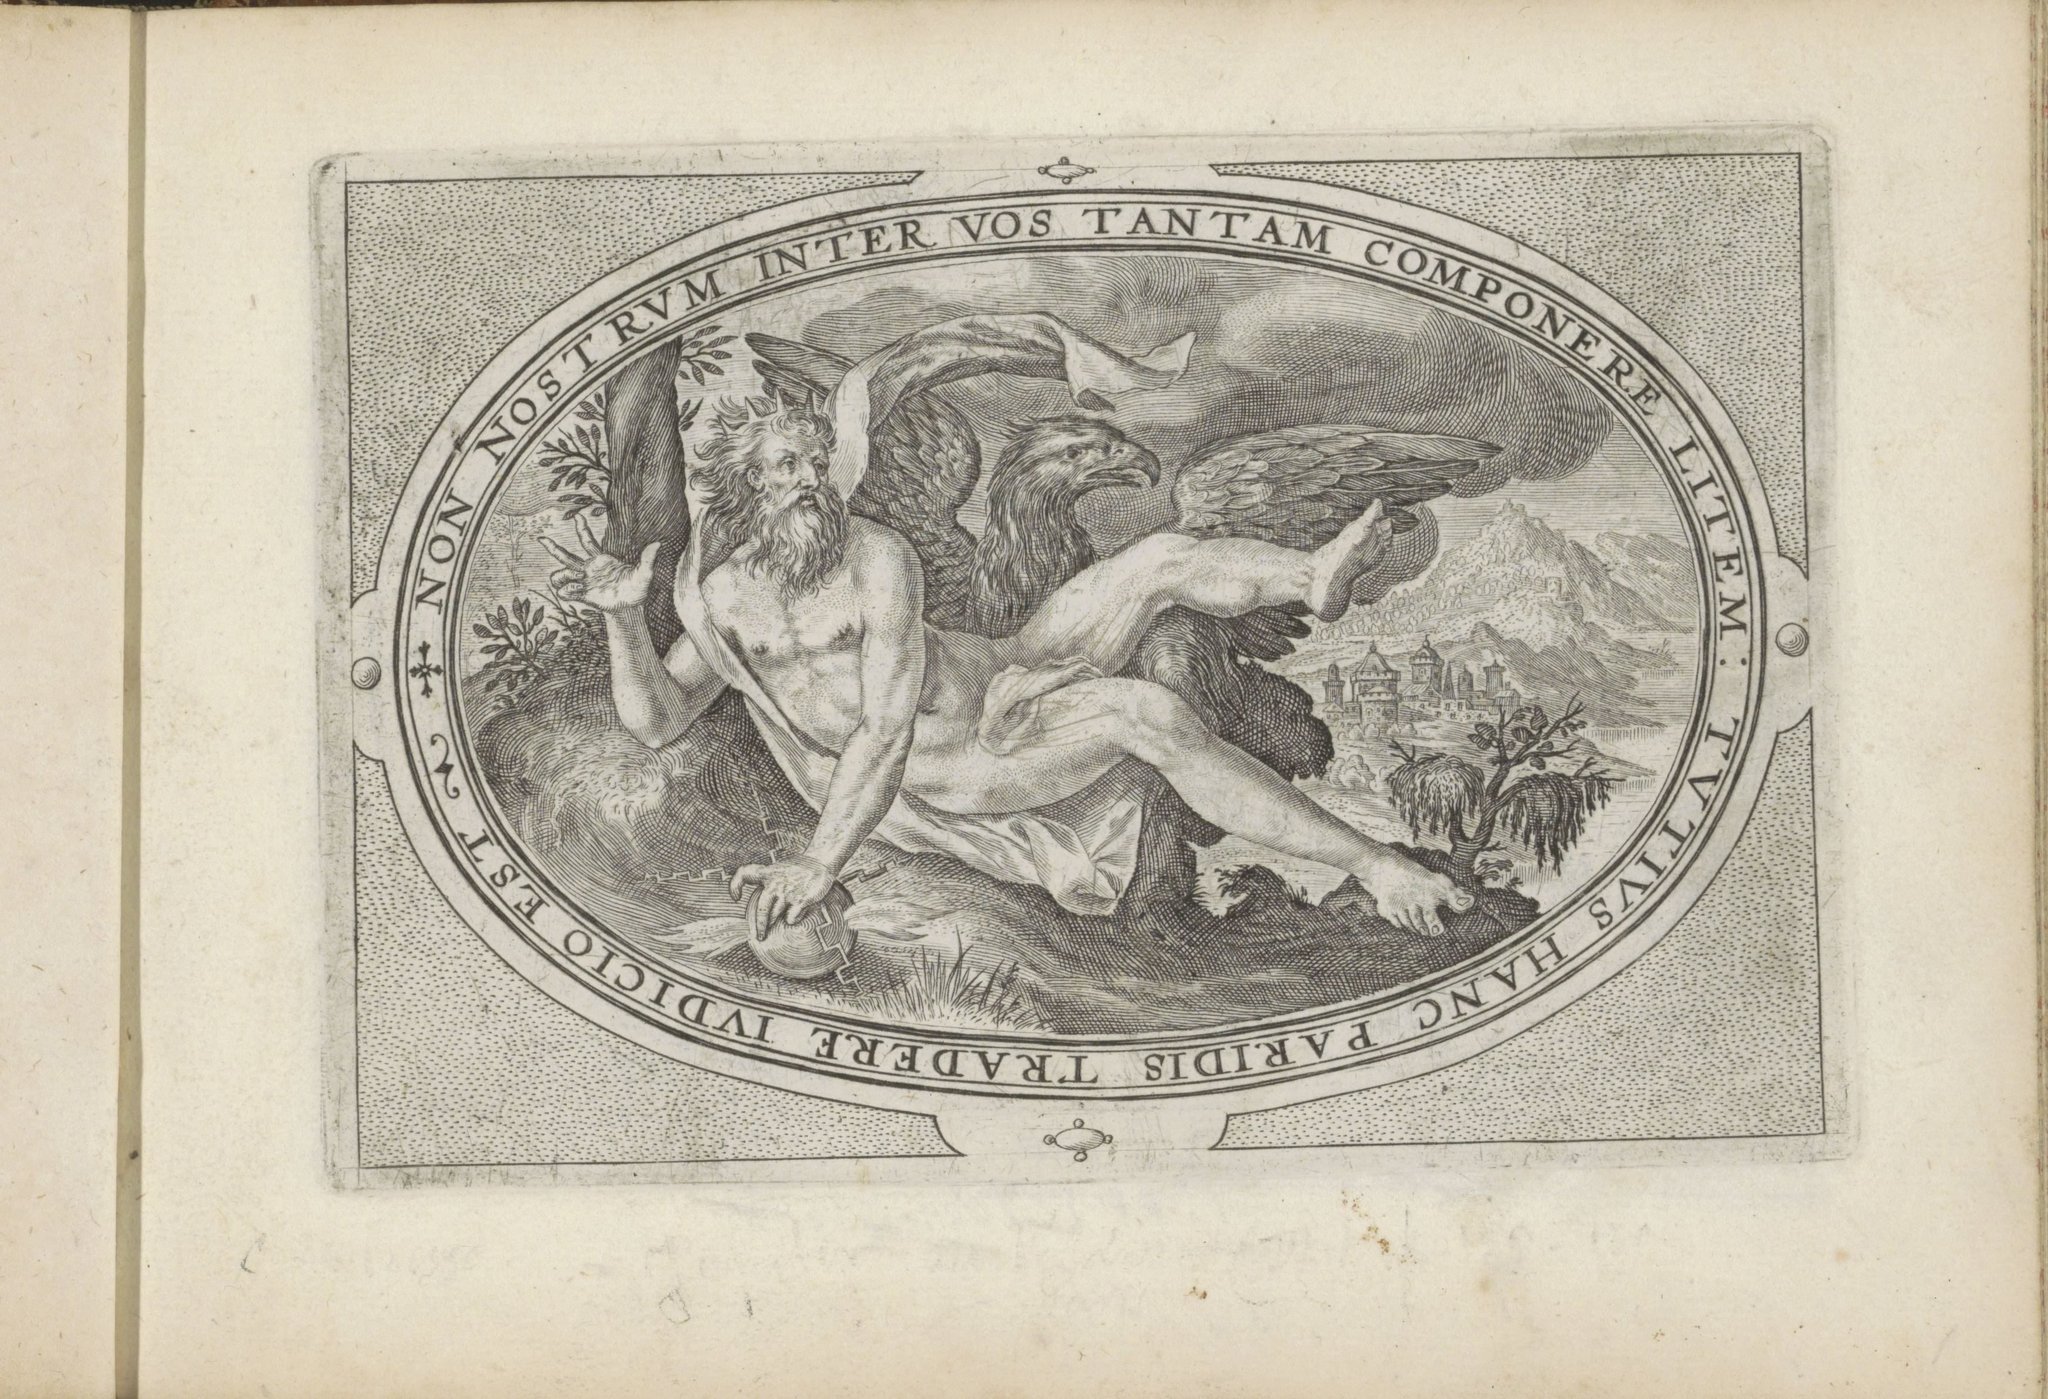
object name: album leaf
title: Jupiter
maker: crispijn van de passe (i)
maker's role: draughtsman, print maker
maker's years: 1564-1637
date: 1592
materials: paper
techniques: engraving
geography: cologne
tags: (story of) jupiter (zeus)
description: Landschap met Jupiter en zijn attribuut de adelaar. Jupiter draagt een kroon en werpt een bliksemschicht. In de omlijsting een randschrift in het Latijn dat verwijst naar de rol die Jupiter speelde in het Oordeel van Paris. Hij wenst zich niet uit te spreken over de godinnen en vindt dat Paris een oordeel moet vellen. Deze prent maakt deel uit van een album.